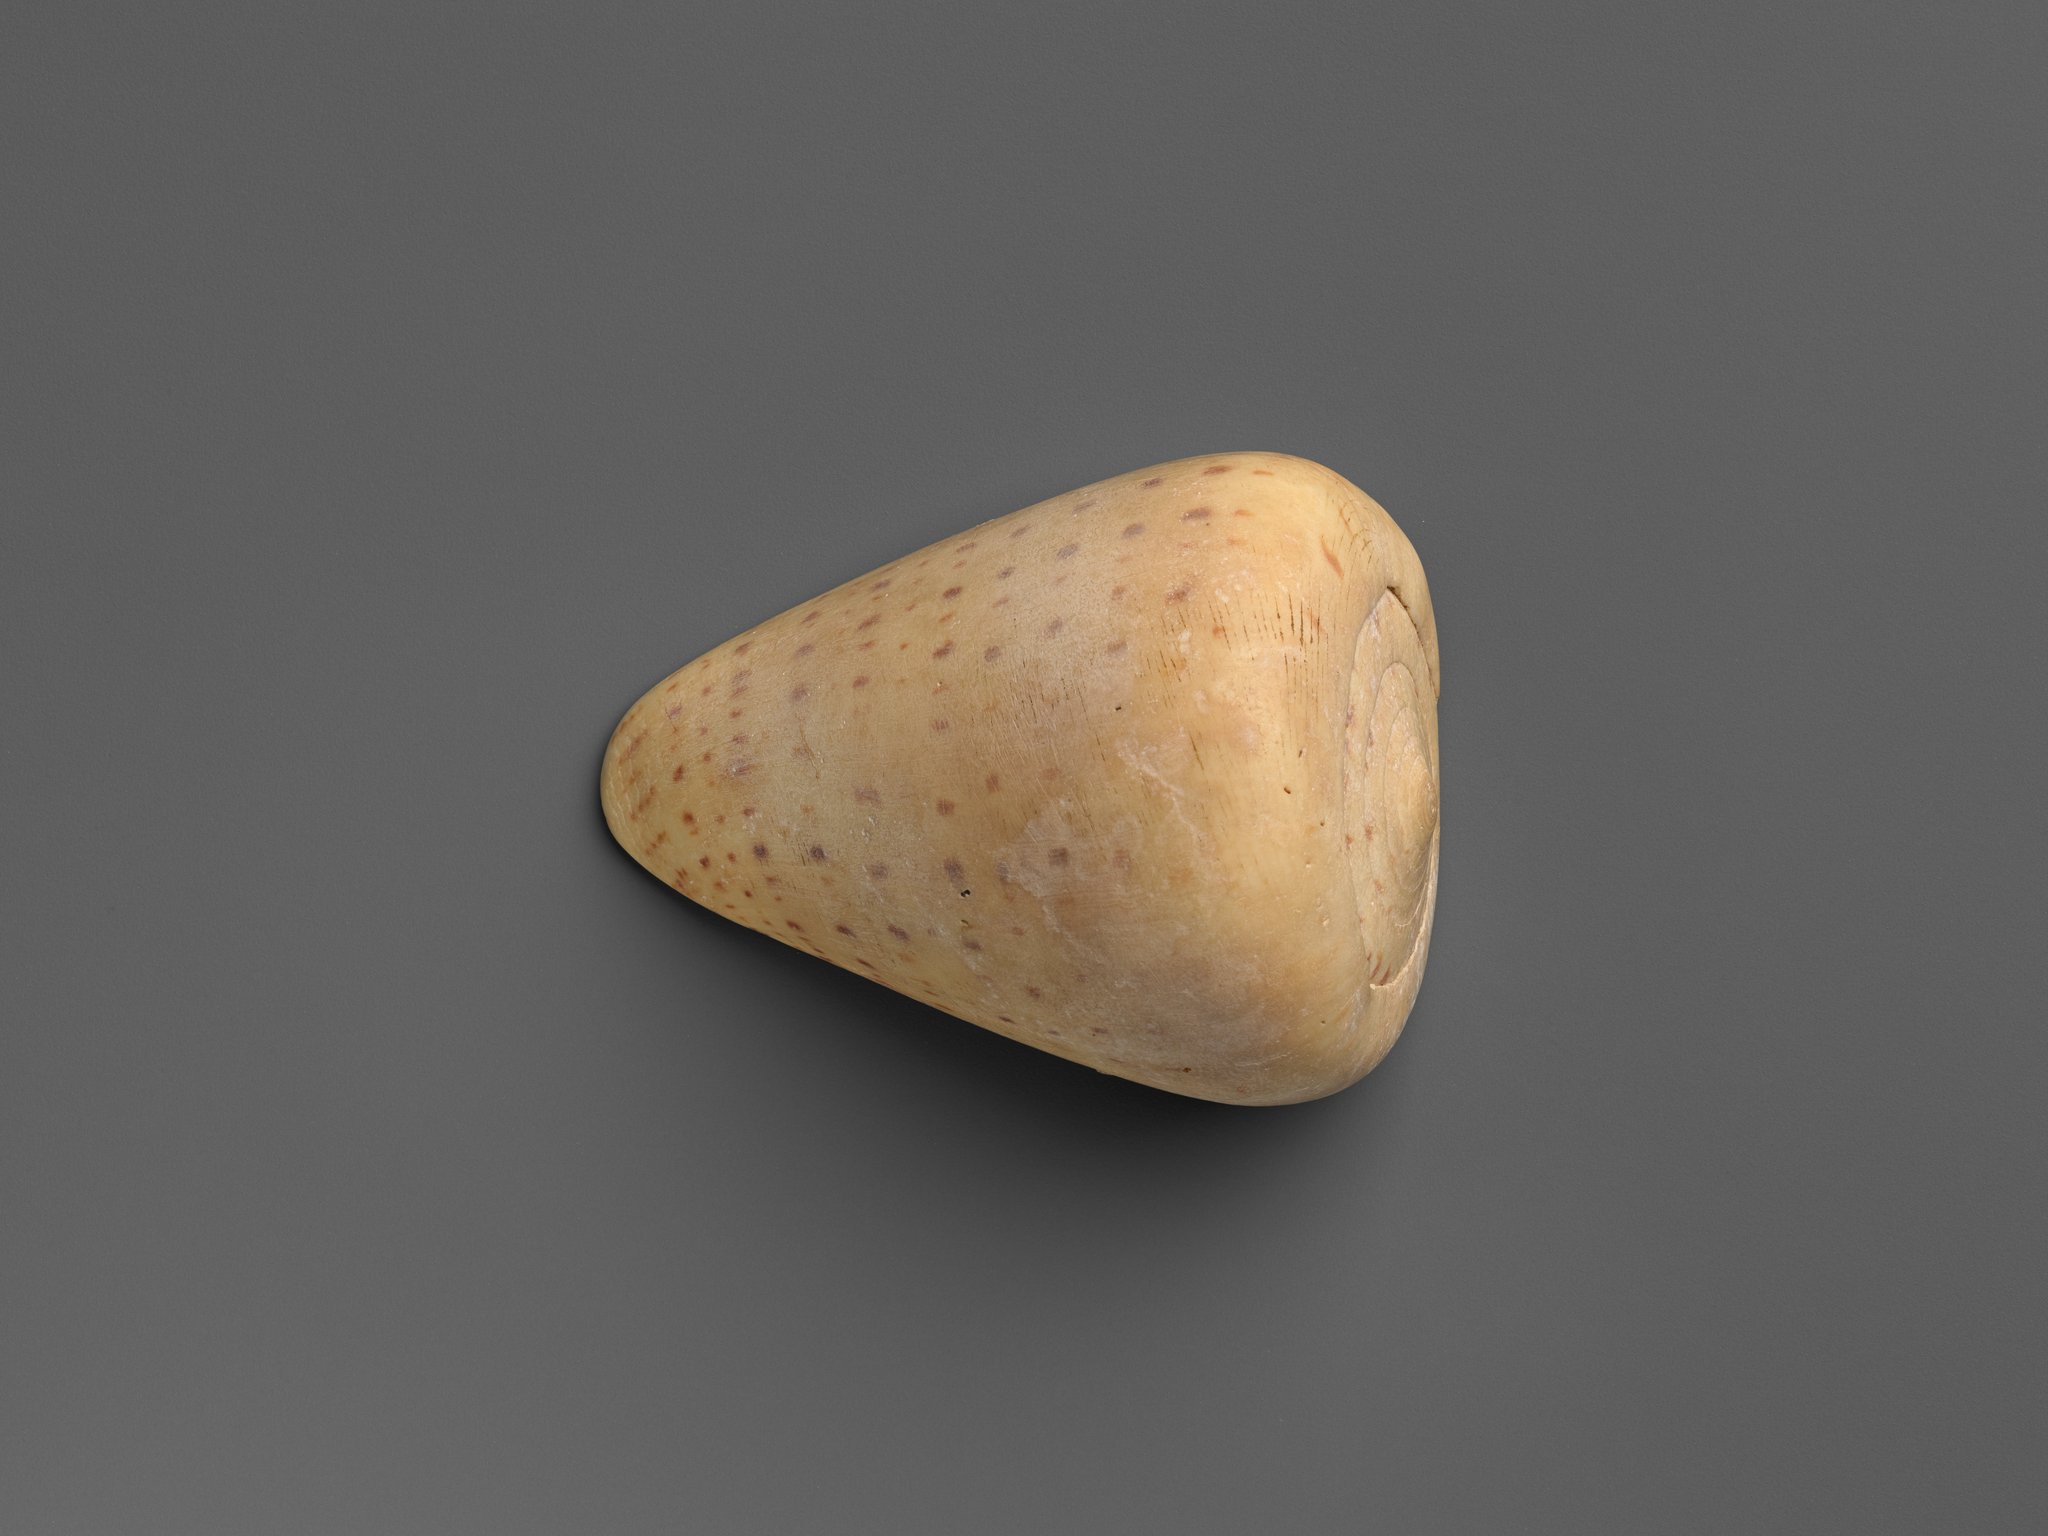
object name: shell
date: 2700-2600 BCE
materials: shell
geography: mesopotamia